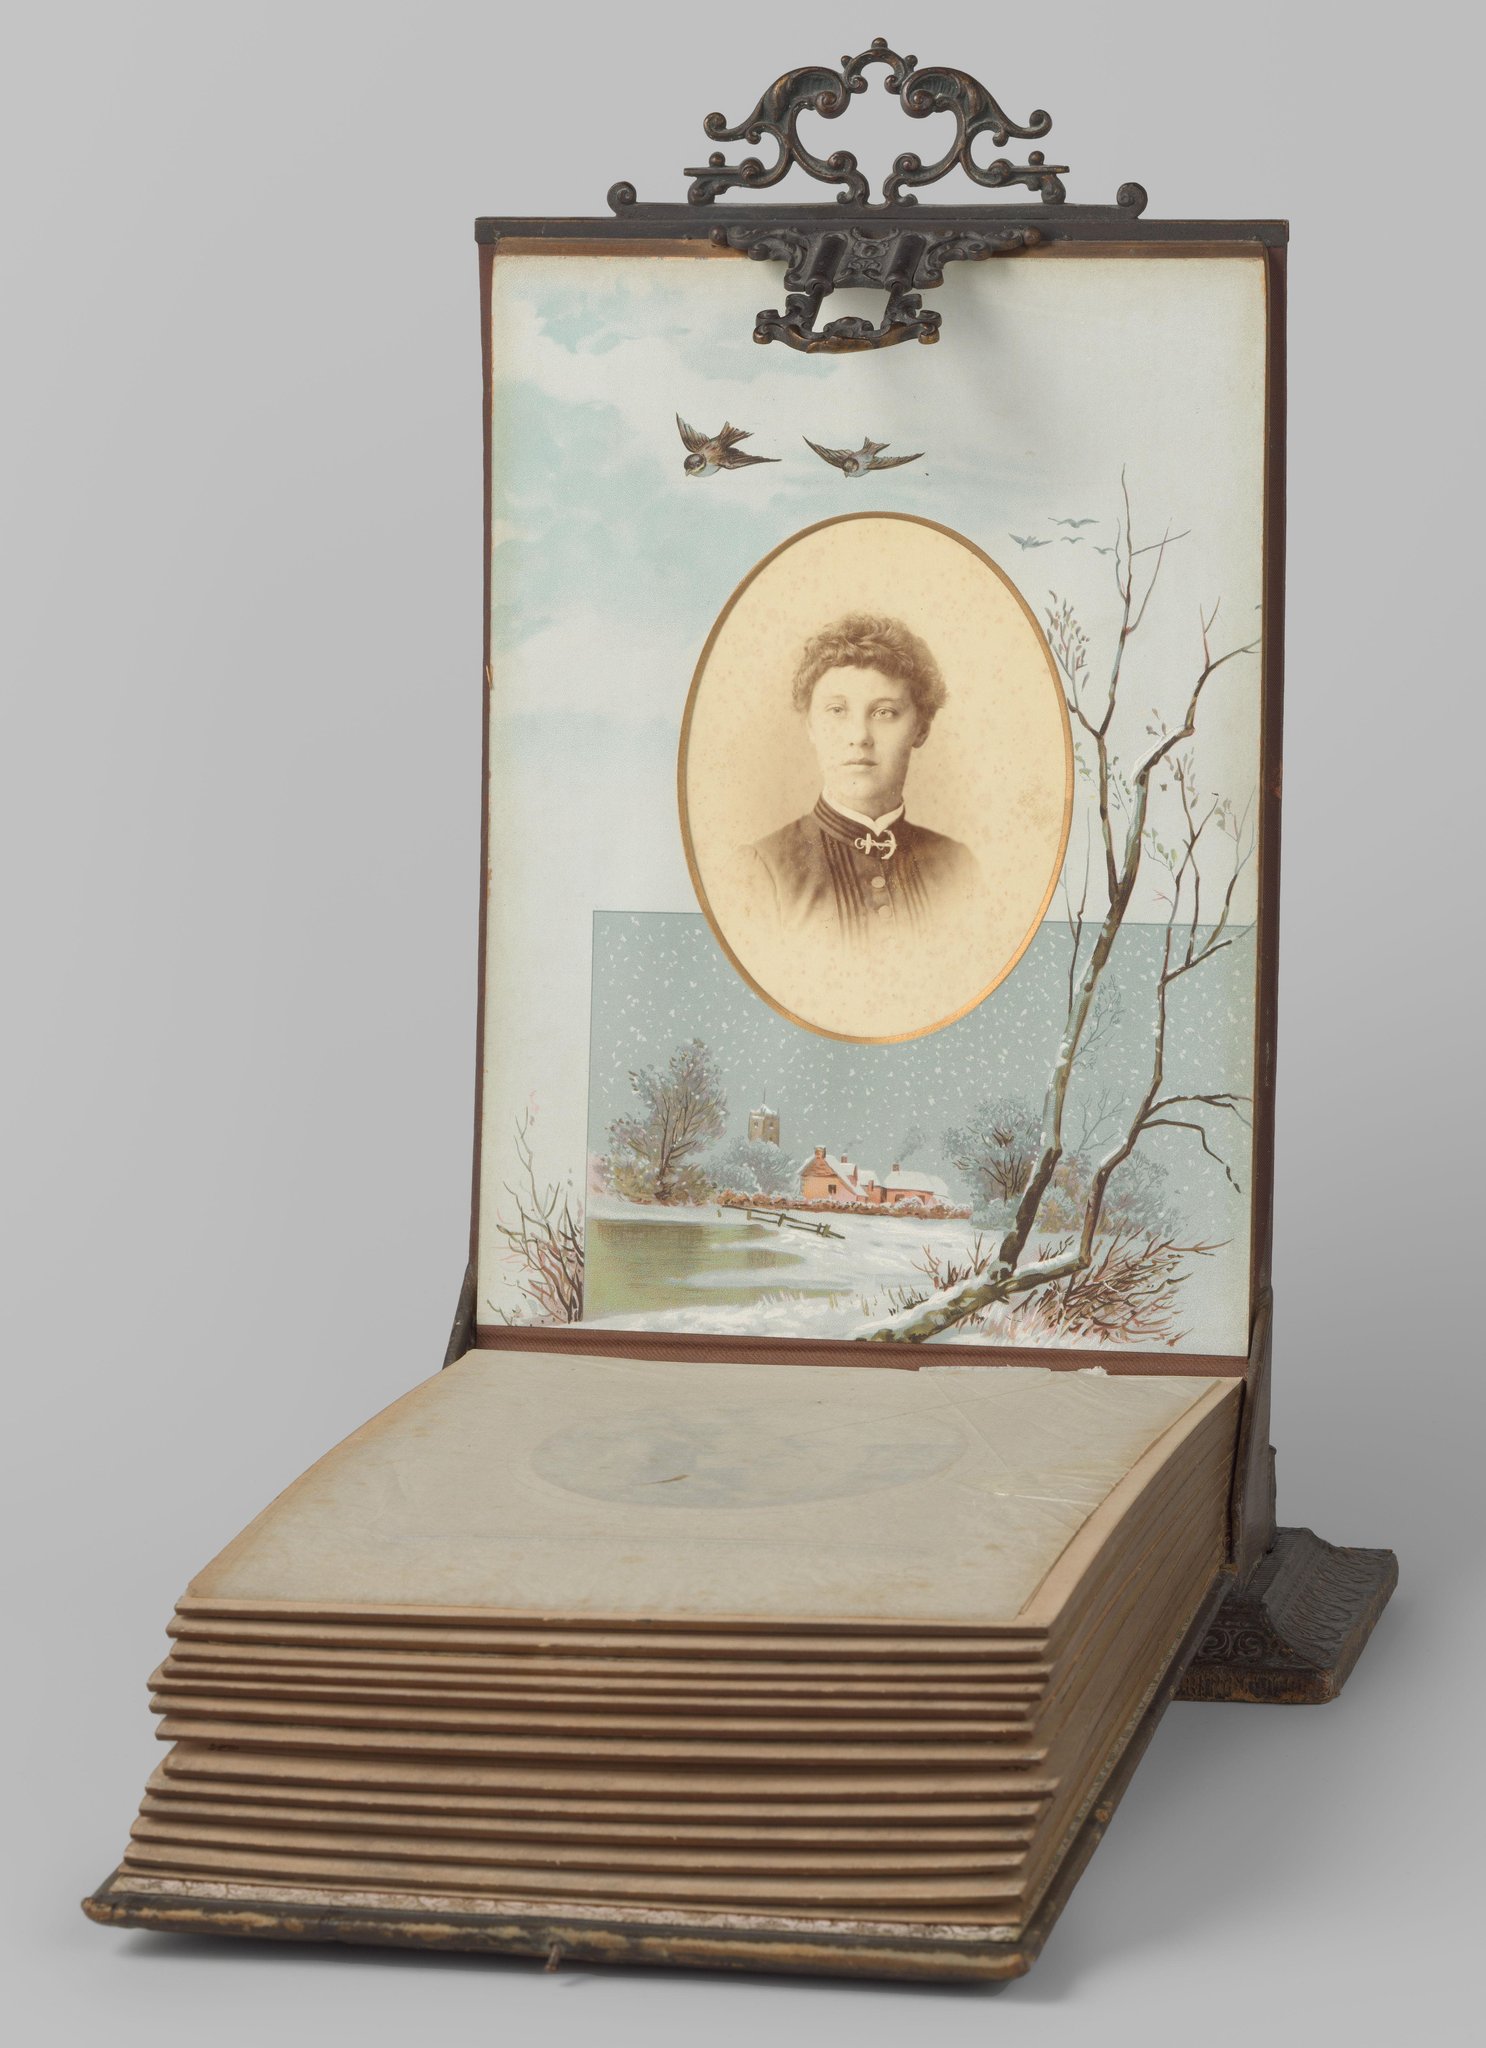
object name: cabinet photograph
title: Portret van een vrouw met halssieraad in de vorm van een anker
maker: william hall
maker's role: fotograaf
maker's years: 1826-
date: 1887-1895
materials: cardboard, photographic support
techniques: albumen print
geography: brighton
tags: historical persons - bb - woman, necklace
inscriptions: inscription: ‘Hall & Son/ 80, WEST STREET/ BRIGHTON.’